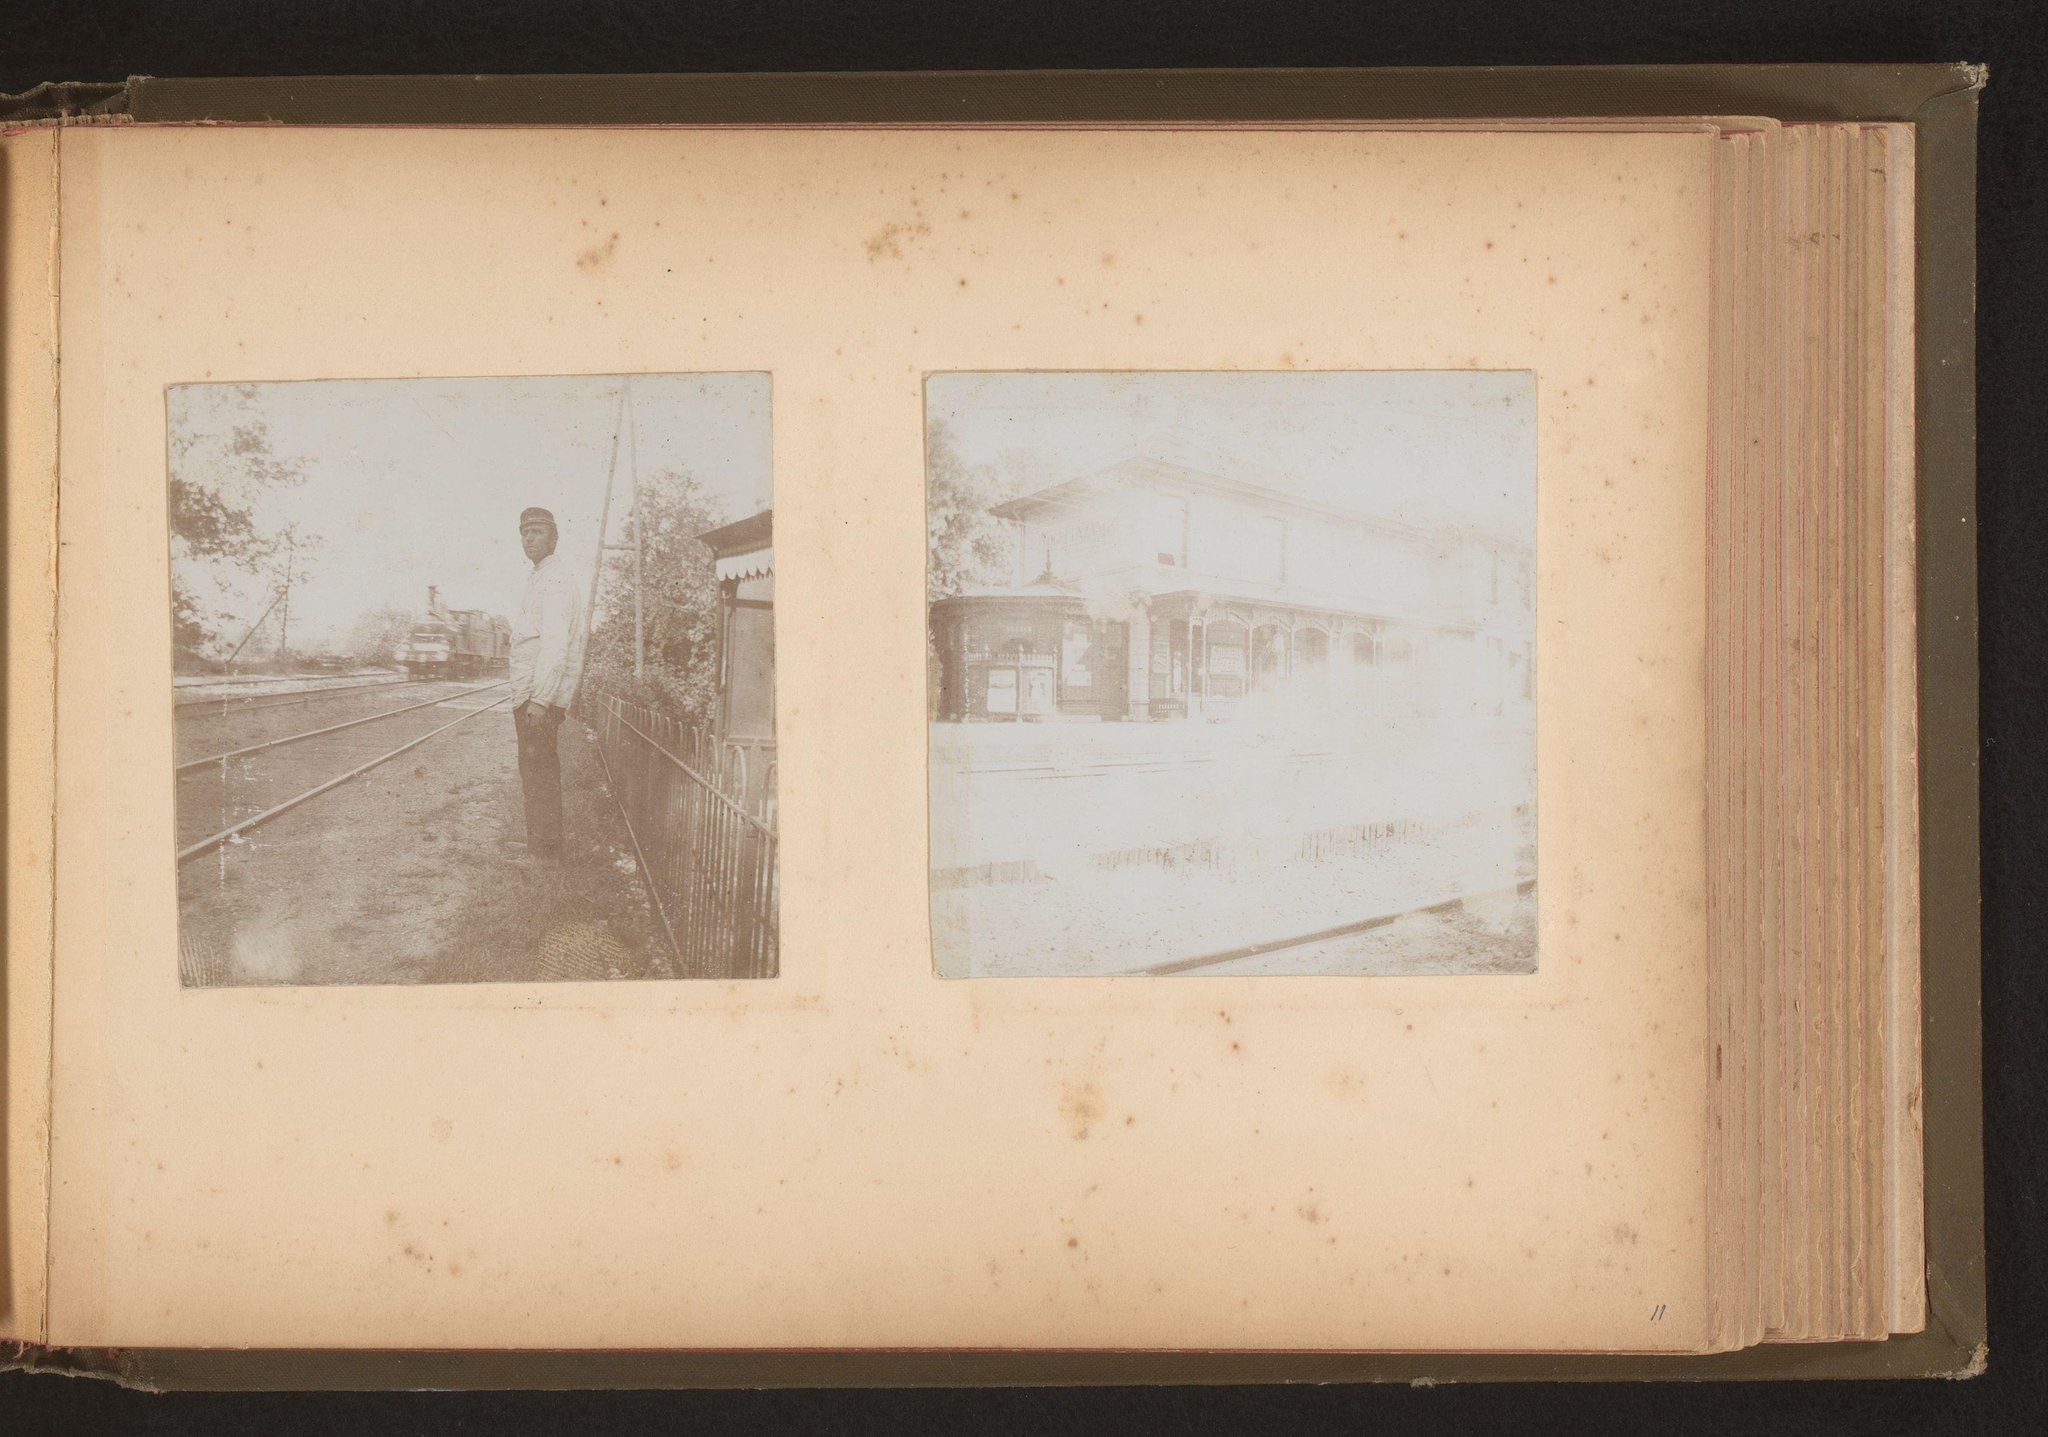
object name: album leaf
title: Twee foto's van de spoorlijn bij station Vogelenzang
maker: Anonymous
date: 1895-1910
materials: paper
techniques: collodion silver print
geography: vogelenzang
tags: station; shelter (railway, tramway), steam locomotive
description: Deze foto's maken deel uit van een album.